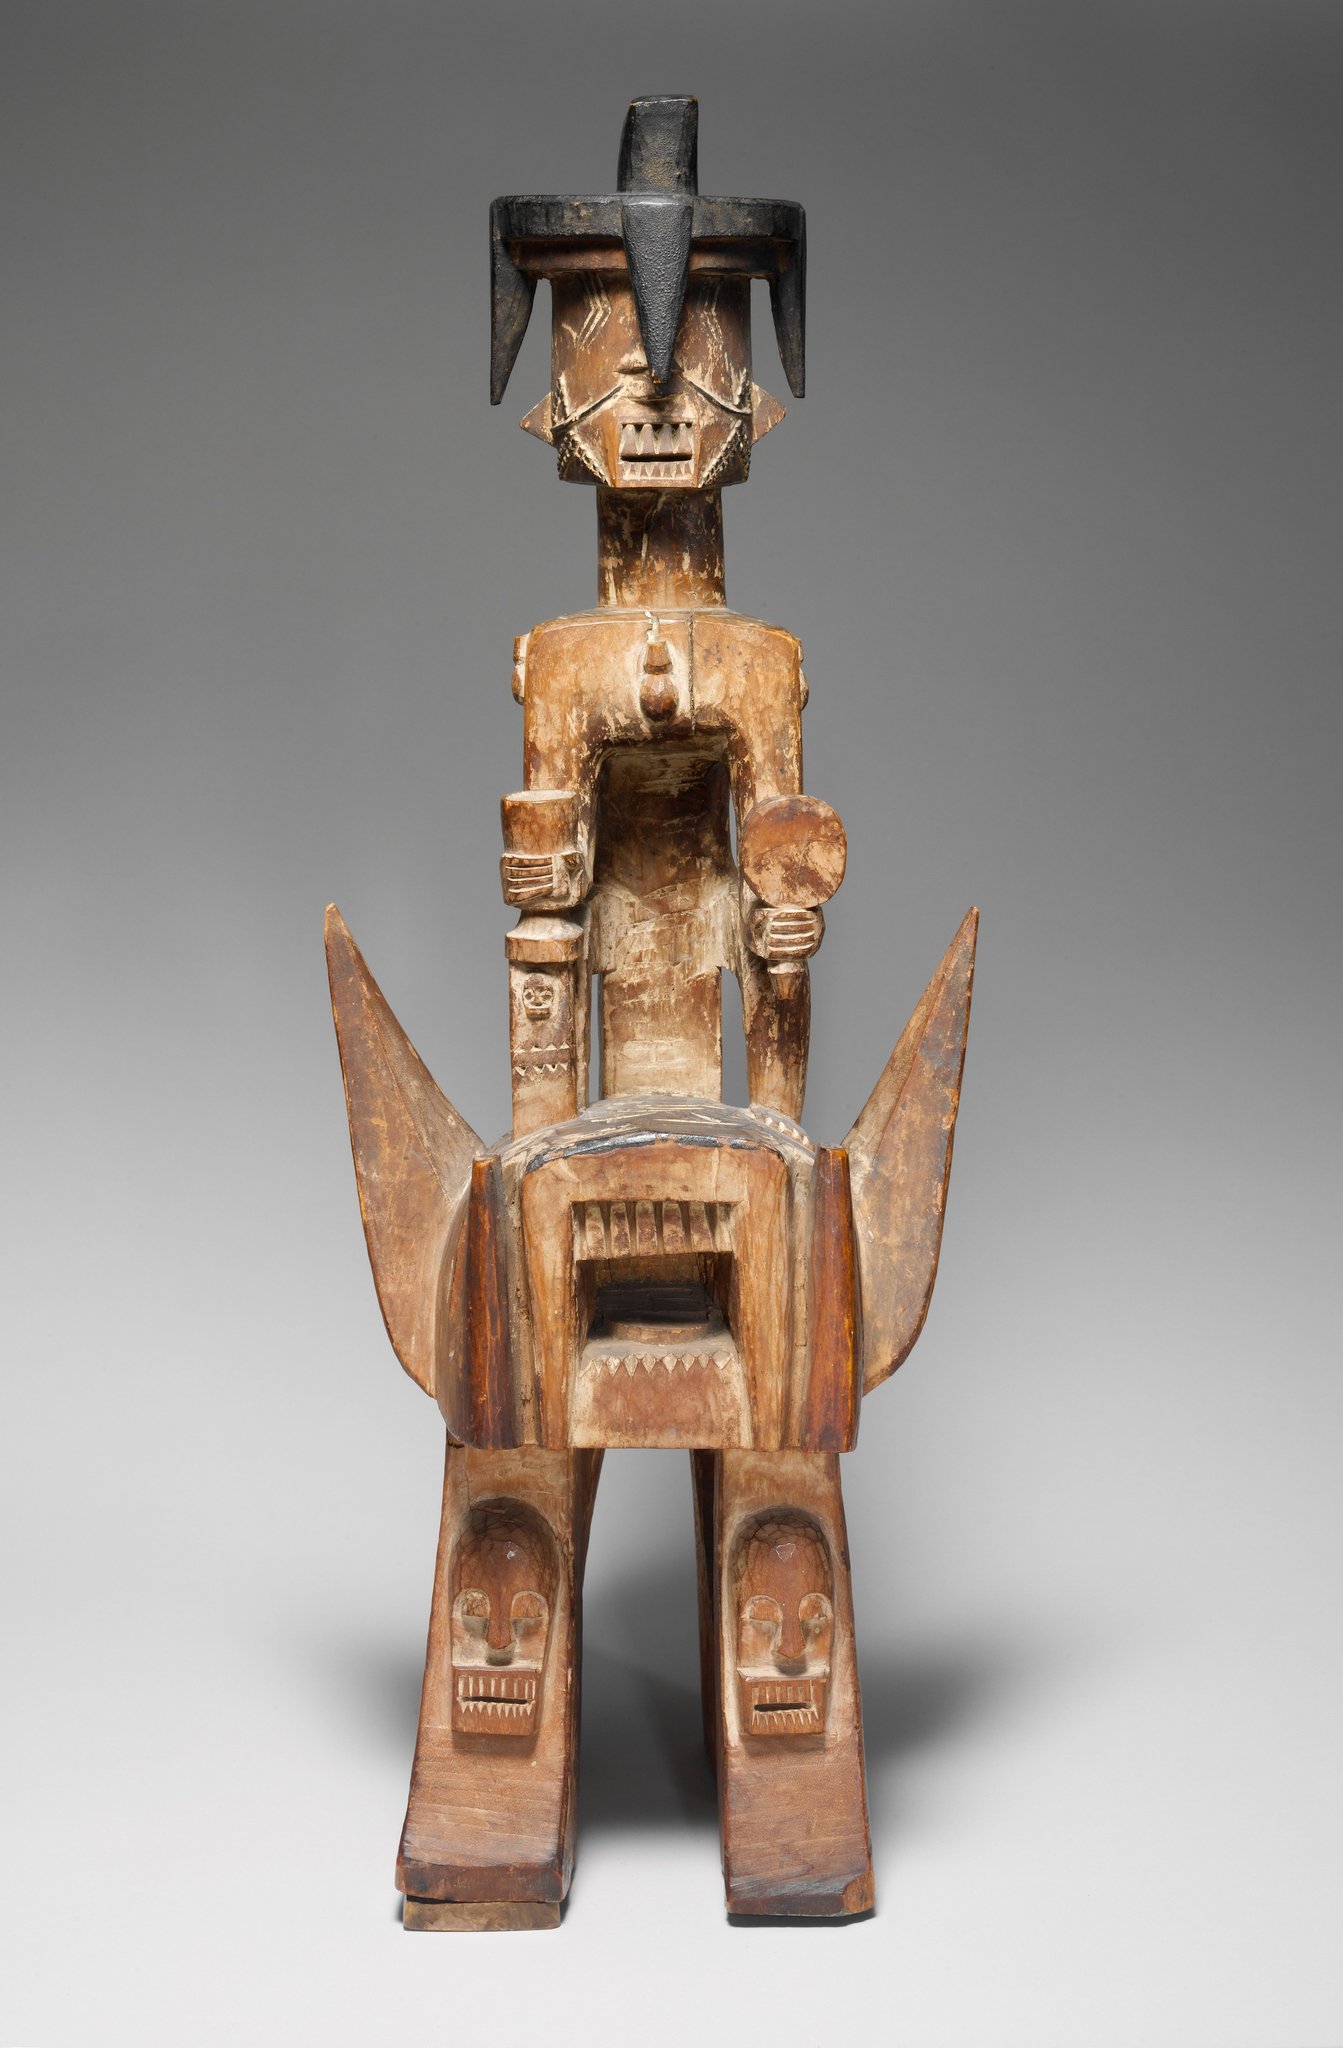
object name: shrine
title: Iphri shrine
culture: ijo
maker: ijo artist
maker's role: artist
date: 1801-1900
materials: pigment, wood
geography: nigeria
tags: animals